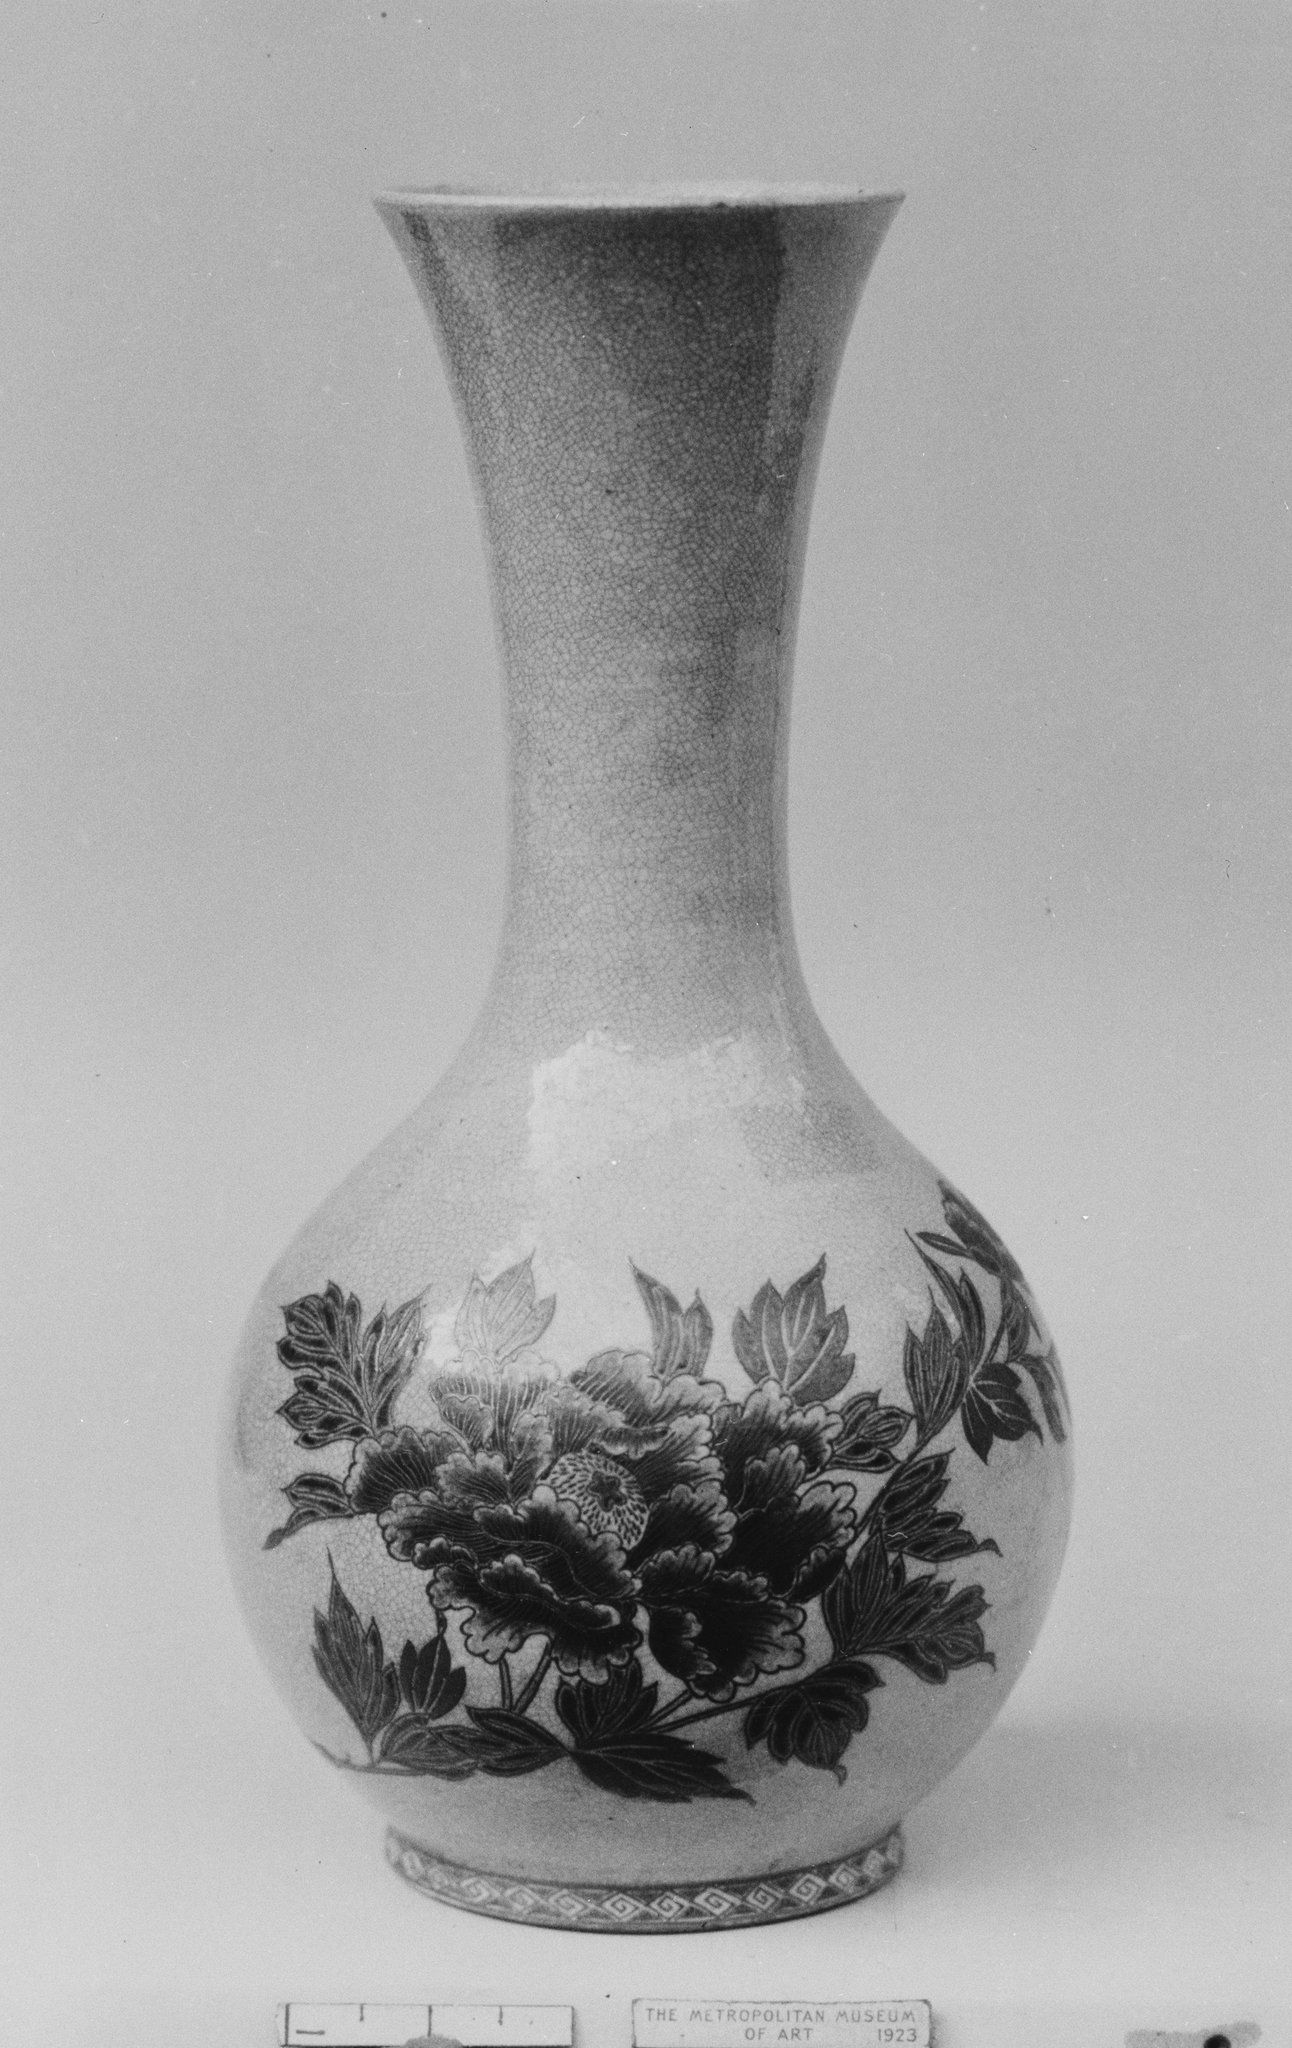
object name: vase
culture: japanese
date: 1820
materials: enamel, faience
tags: flowers,leaves